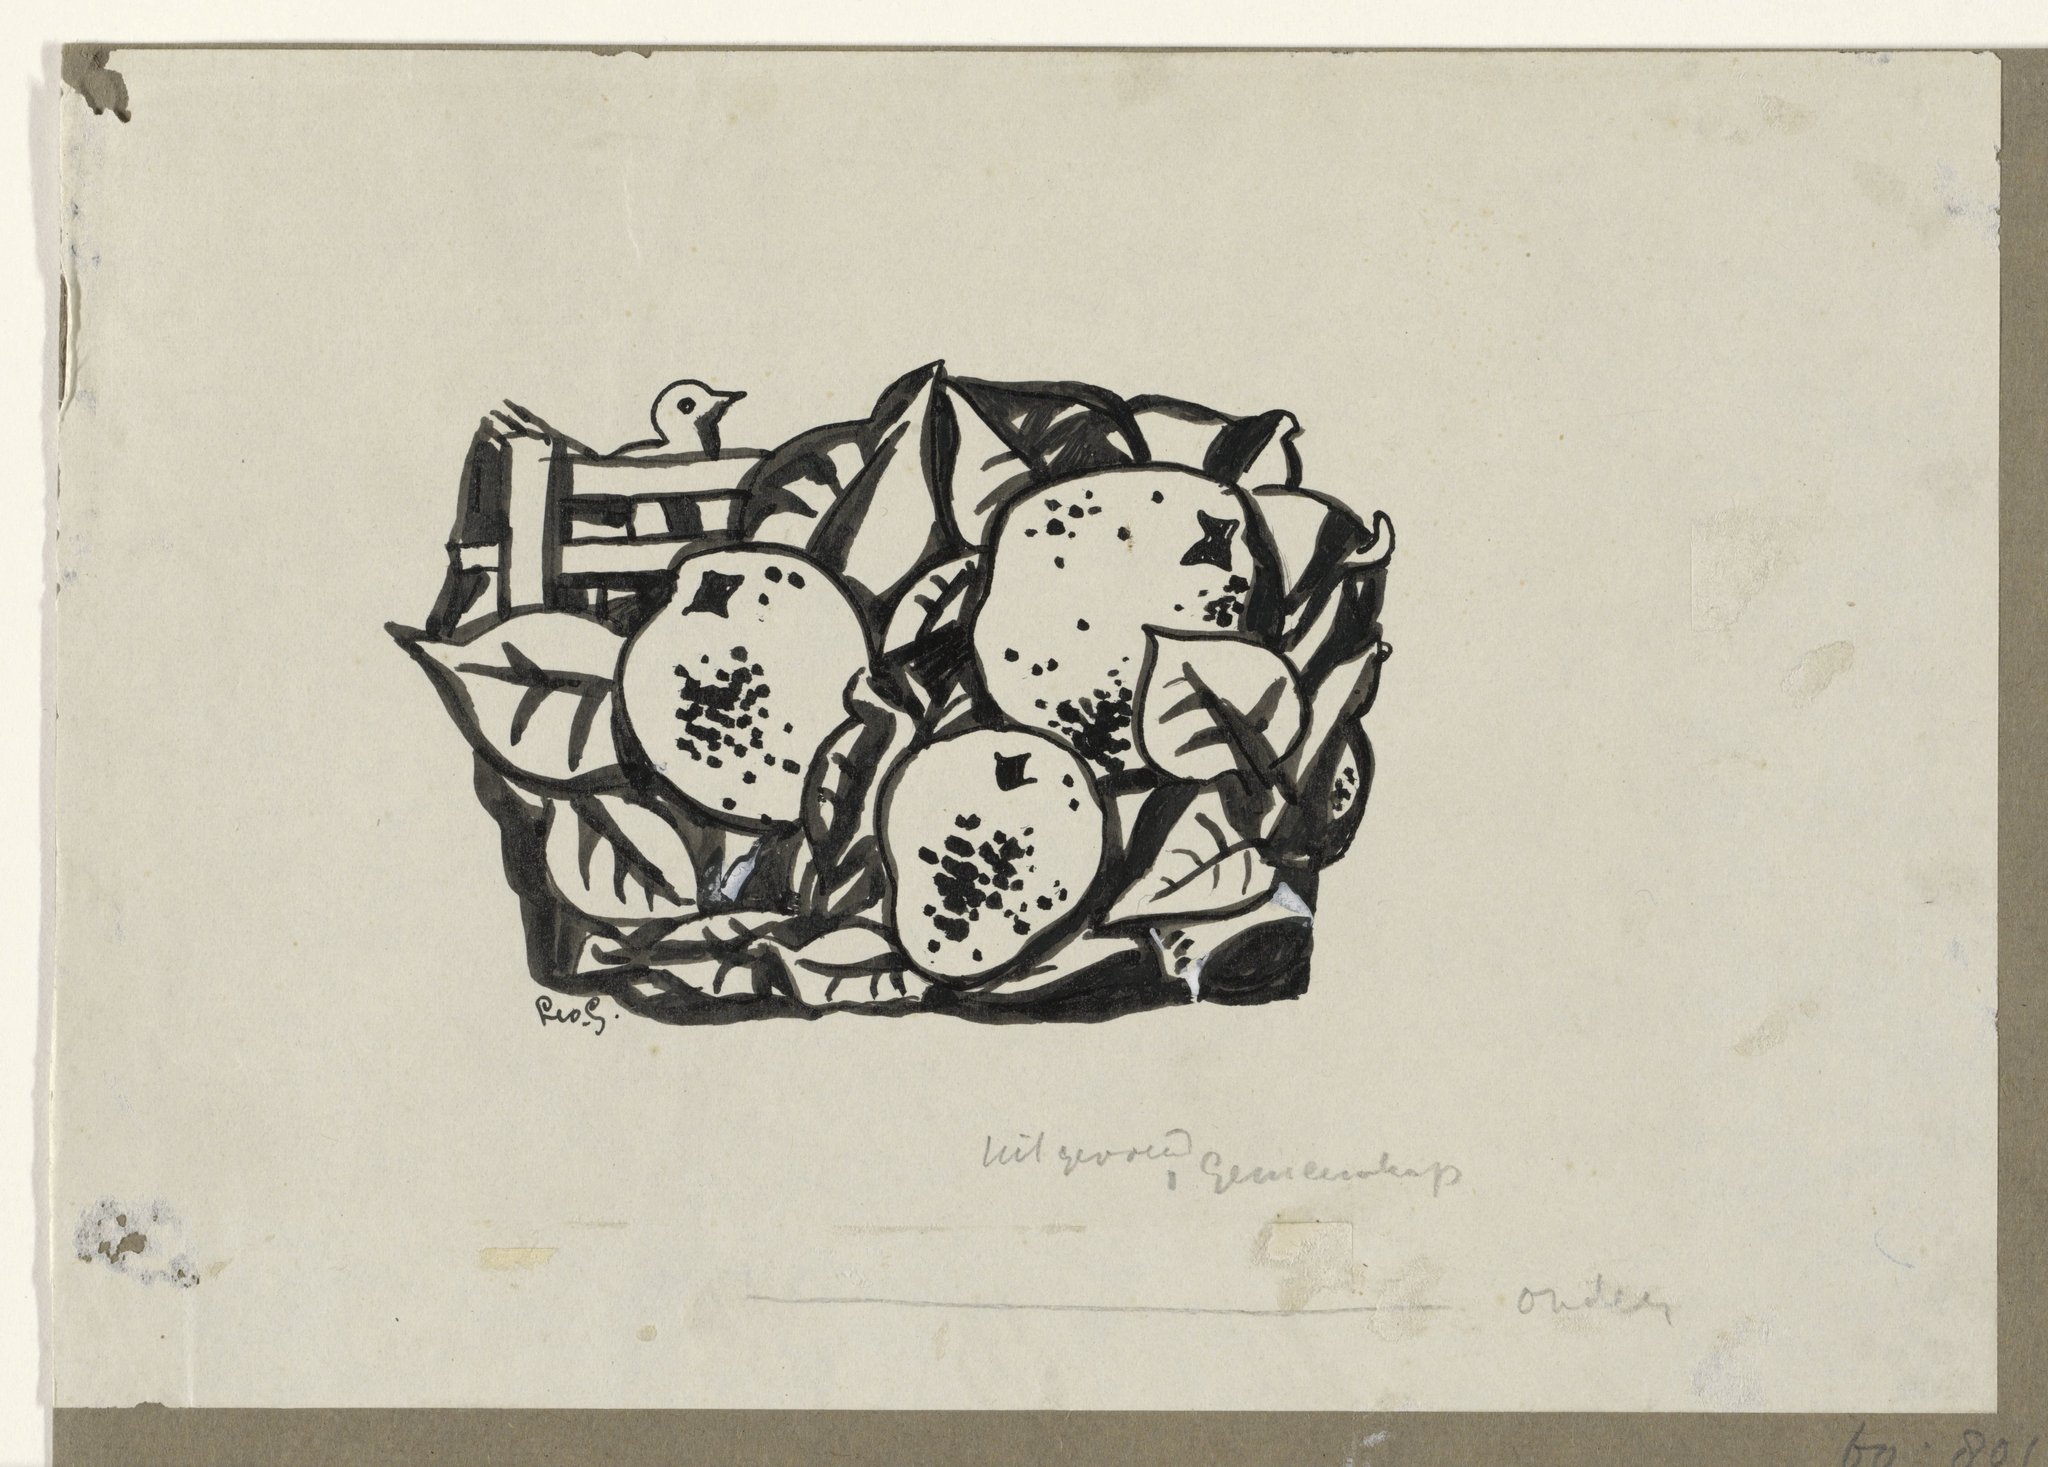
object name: drawing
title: Drie peren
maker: leo gestel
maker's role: draughtsman, print maker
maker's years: 1881-1941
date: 1925-1941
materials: paint, ink, paper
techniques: brush, pen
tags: fruits: pear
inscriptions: clichéaanwijzing, recto, handgeschreven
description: Ontwerp voor een illustratie voor: De Gemeenschap, uitgegeven tussen 1925-1941.